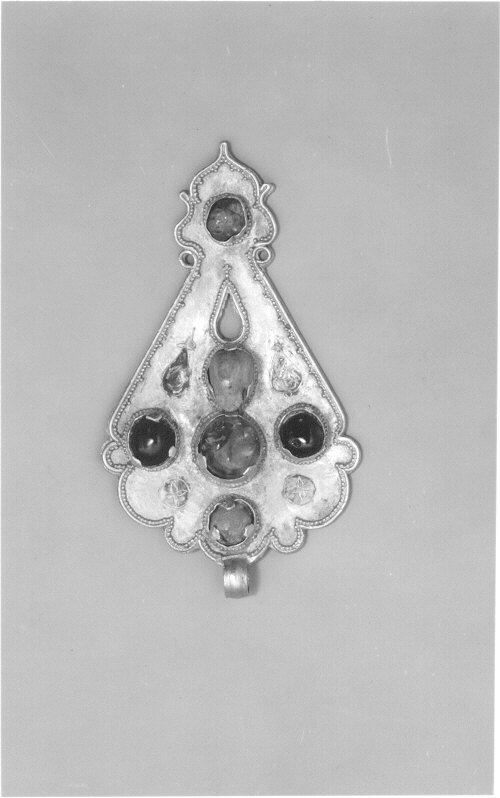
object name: pendant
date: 1001-1100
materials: garnet, gold, stone, metal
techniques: highlighting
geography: iran